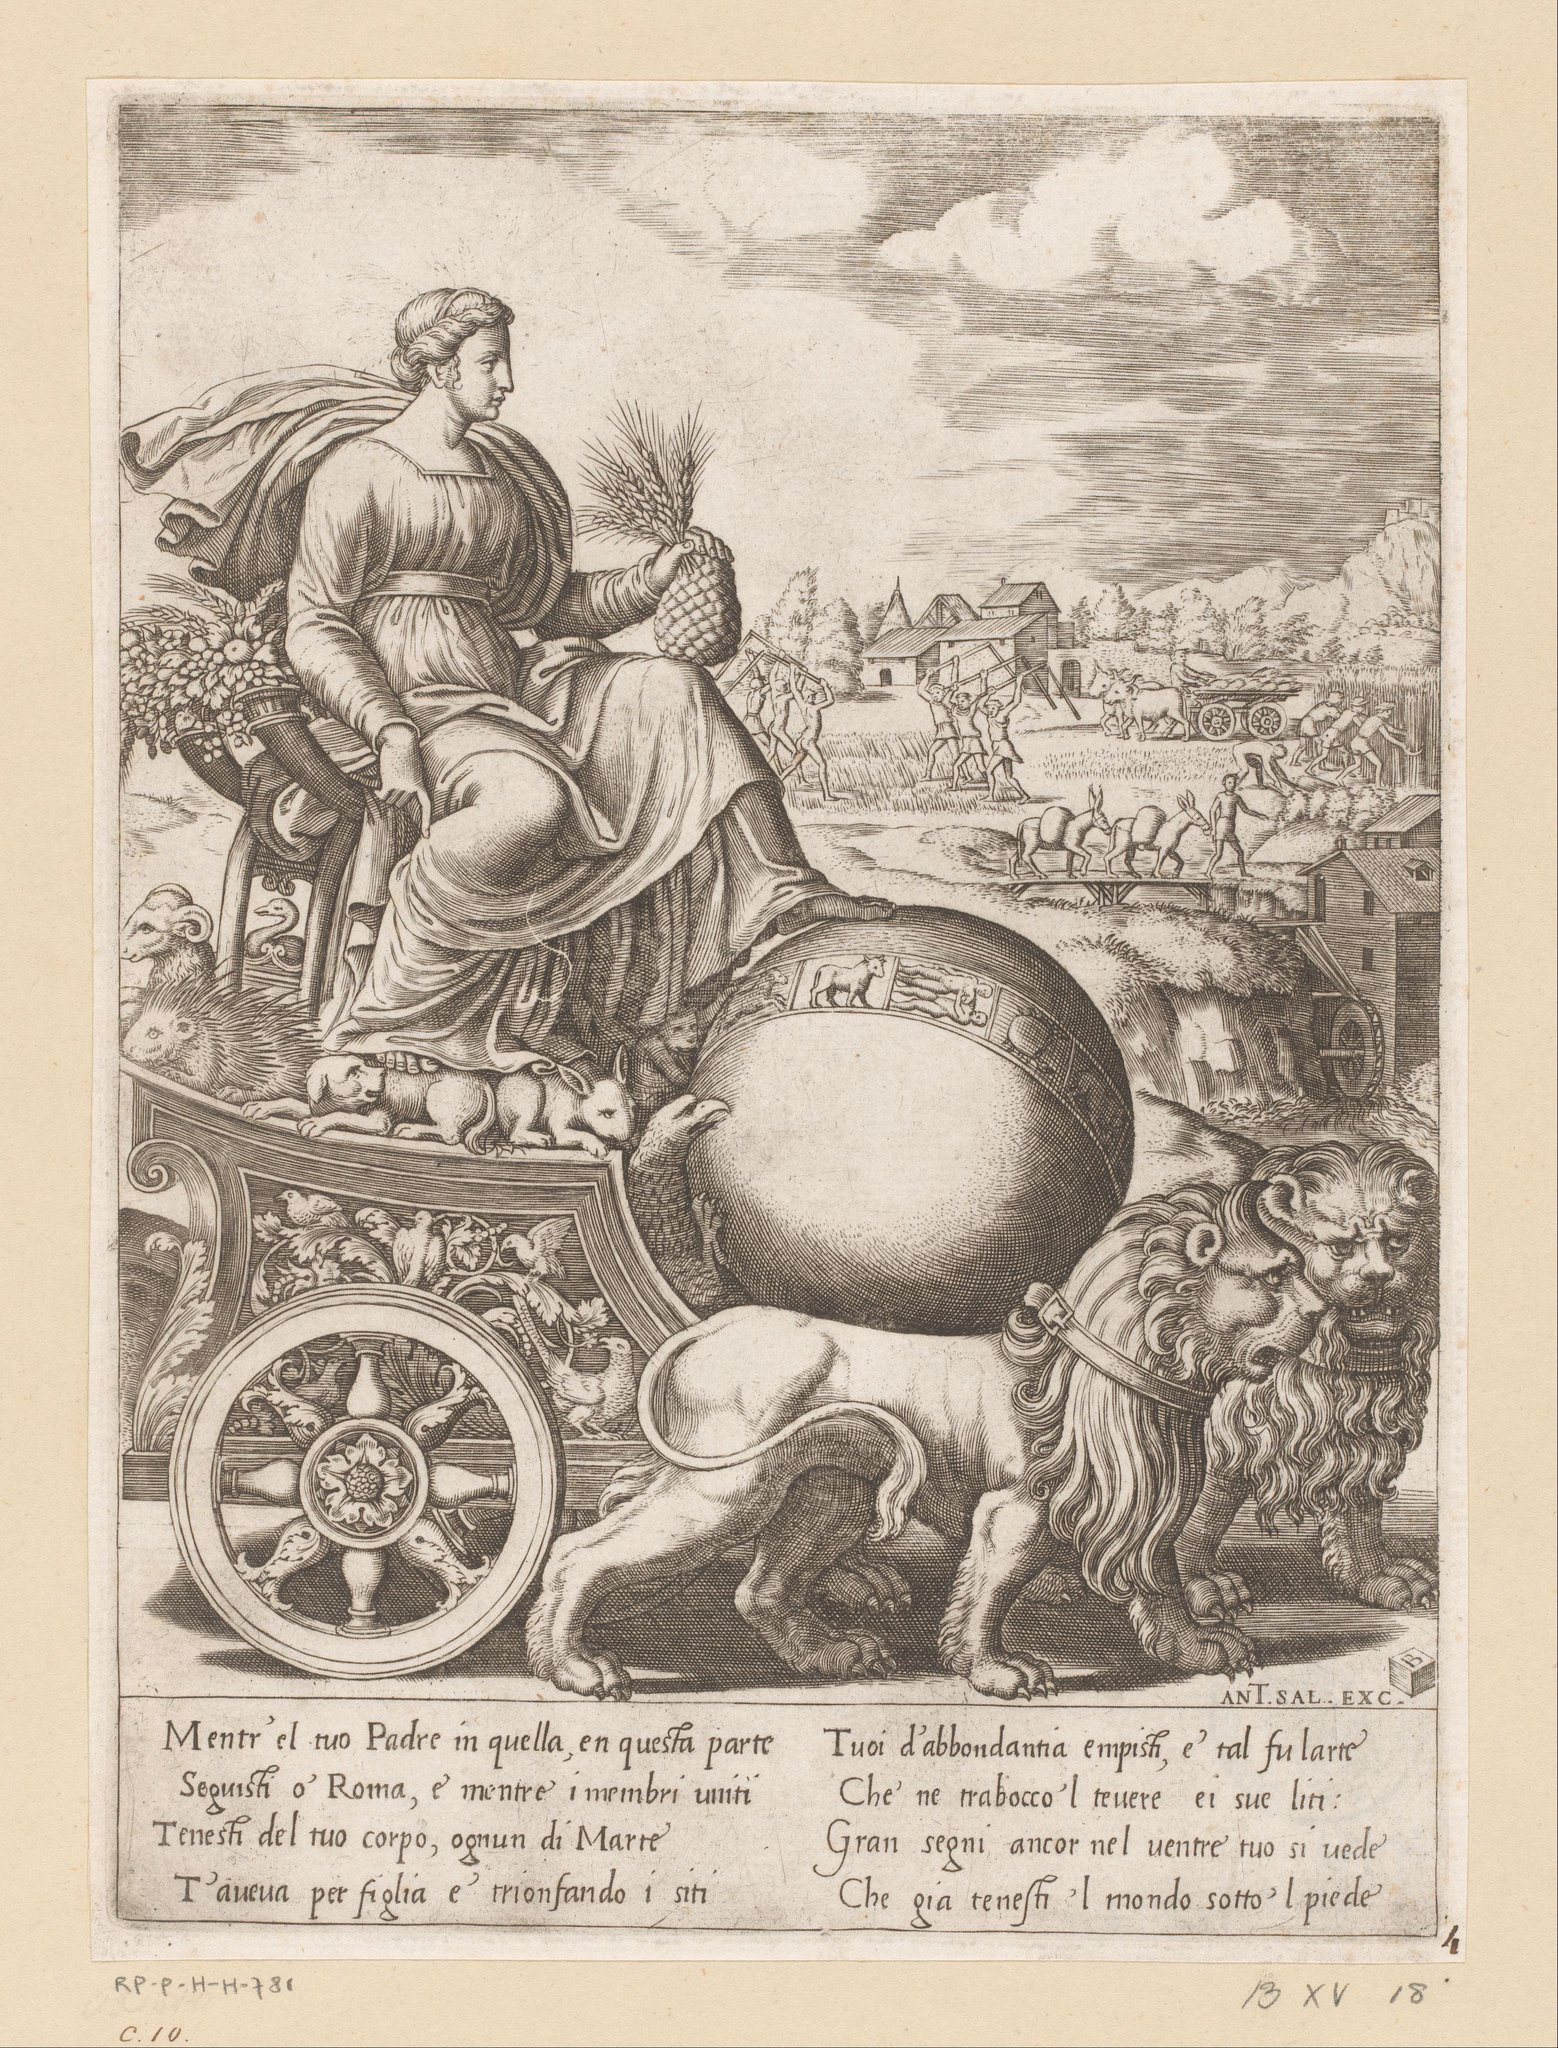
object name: print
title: Cybele op haar wagen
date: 1530-1560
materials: paper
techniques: engraving, intaglio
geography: rome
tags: (story of) cybele, rhea cybele, great mother of the gods (berecynt(h)ia), chariot, triumphal car, soil cultivation, zodiac; the twelve zodiacal signs together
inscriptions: collector's mark: ‘Hinloopen’, collector's mark: Lugt 11, number: ‘4’, collector's mark: Lugt 10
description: De 'aardmoeder' Cybele op een door leeuwen getrokken wagen. In haar handen korenaren en een dennenappel. Onder haar voeten verscheidene dieren en onder haar voet een bol met de tekens van de dierenriem. Op de achtergrond figuren die op het land werken. Italiaanse tekst in twee kolommen in ondermarge.